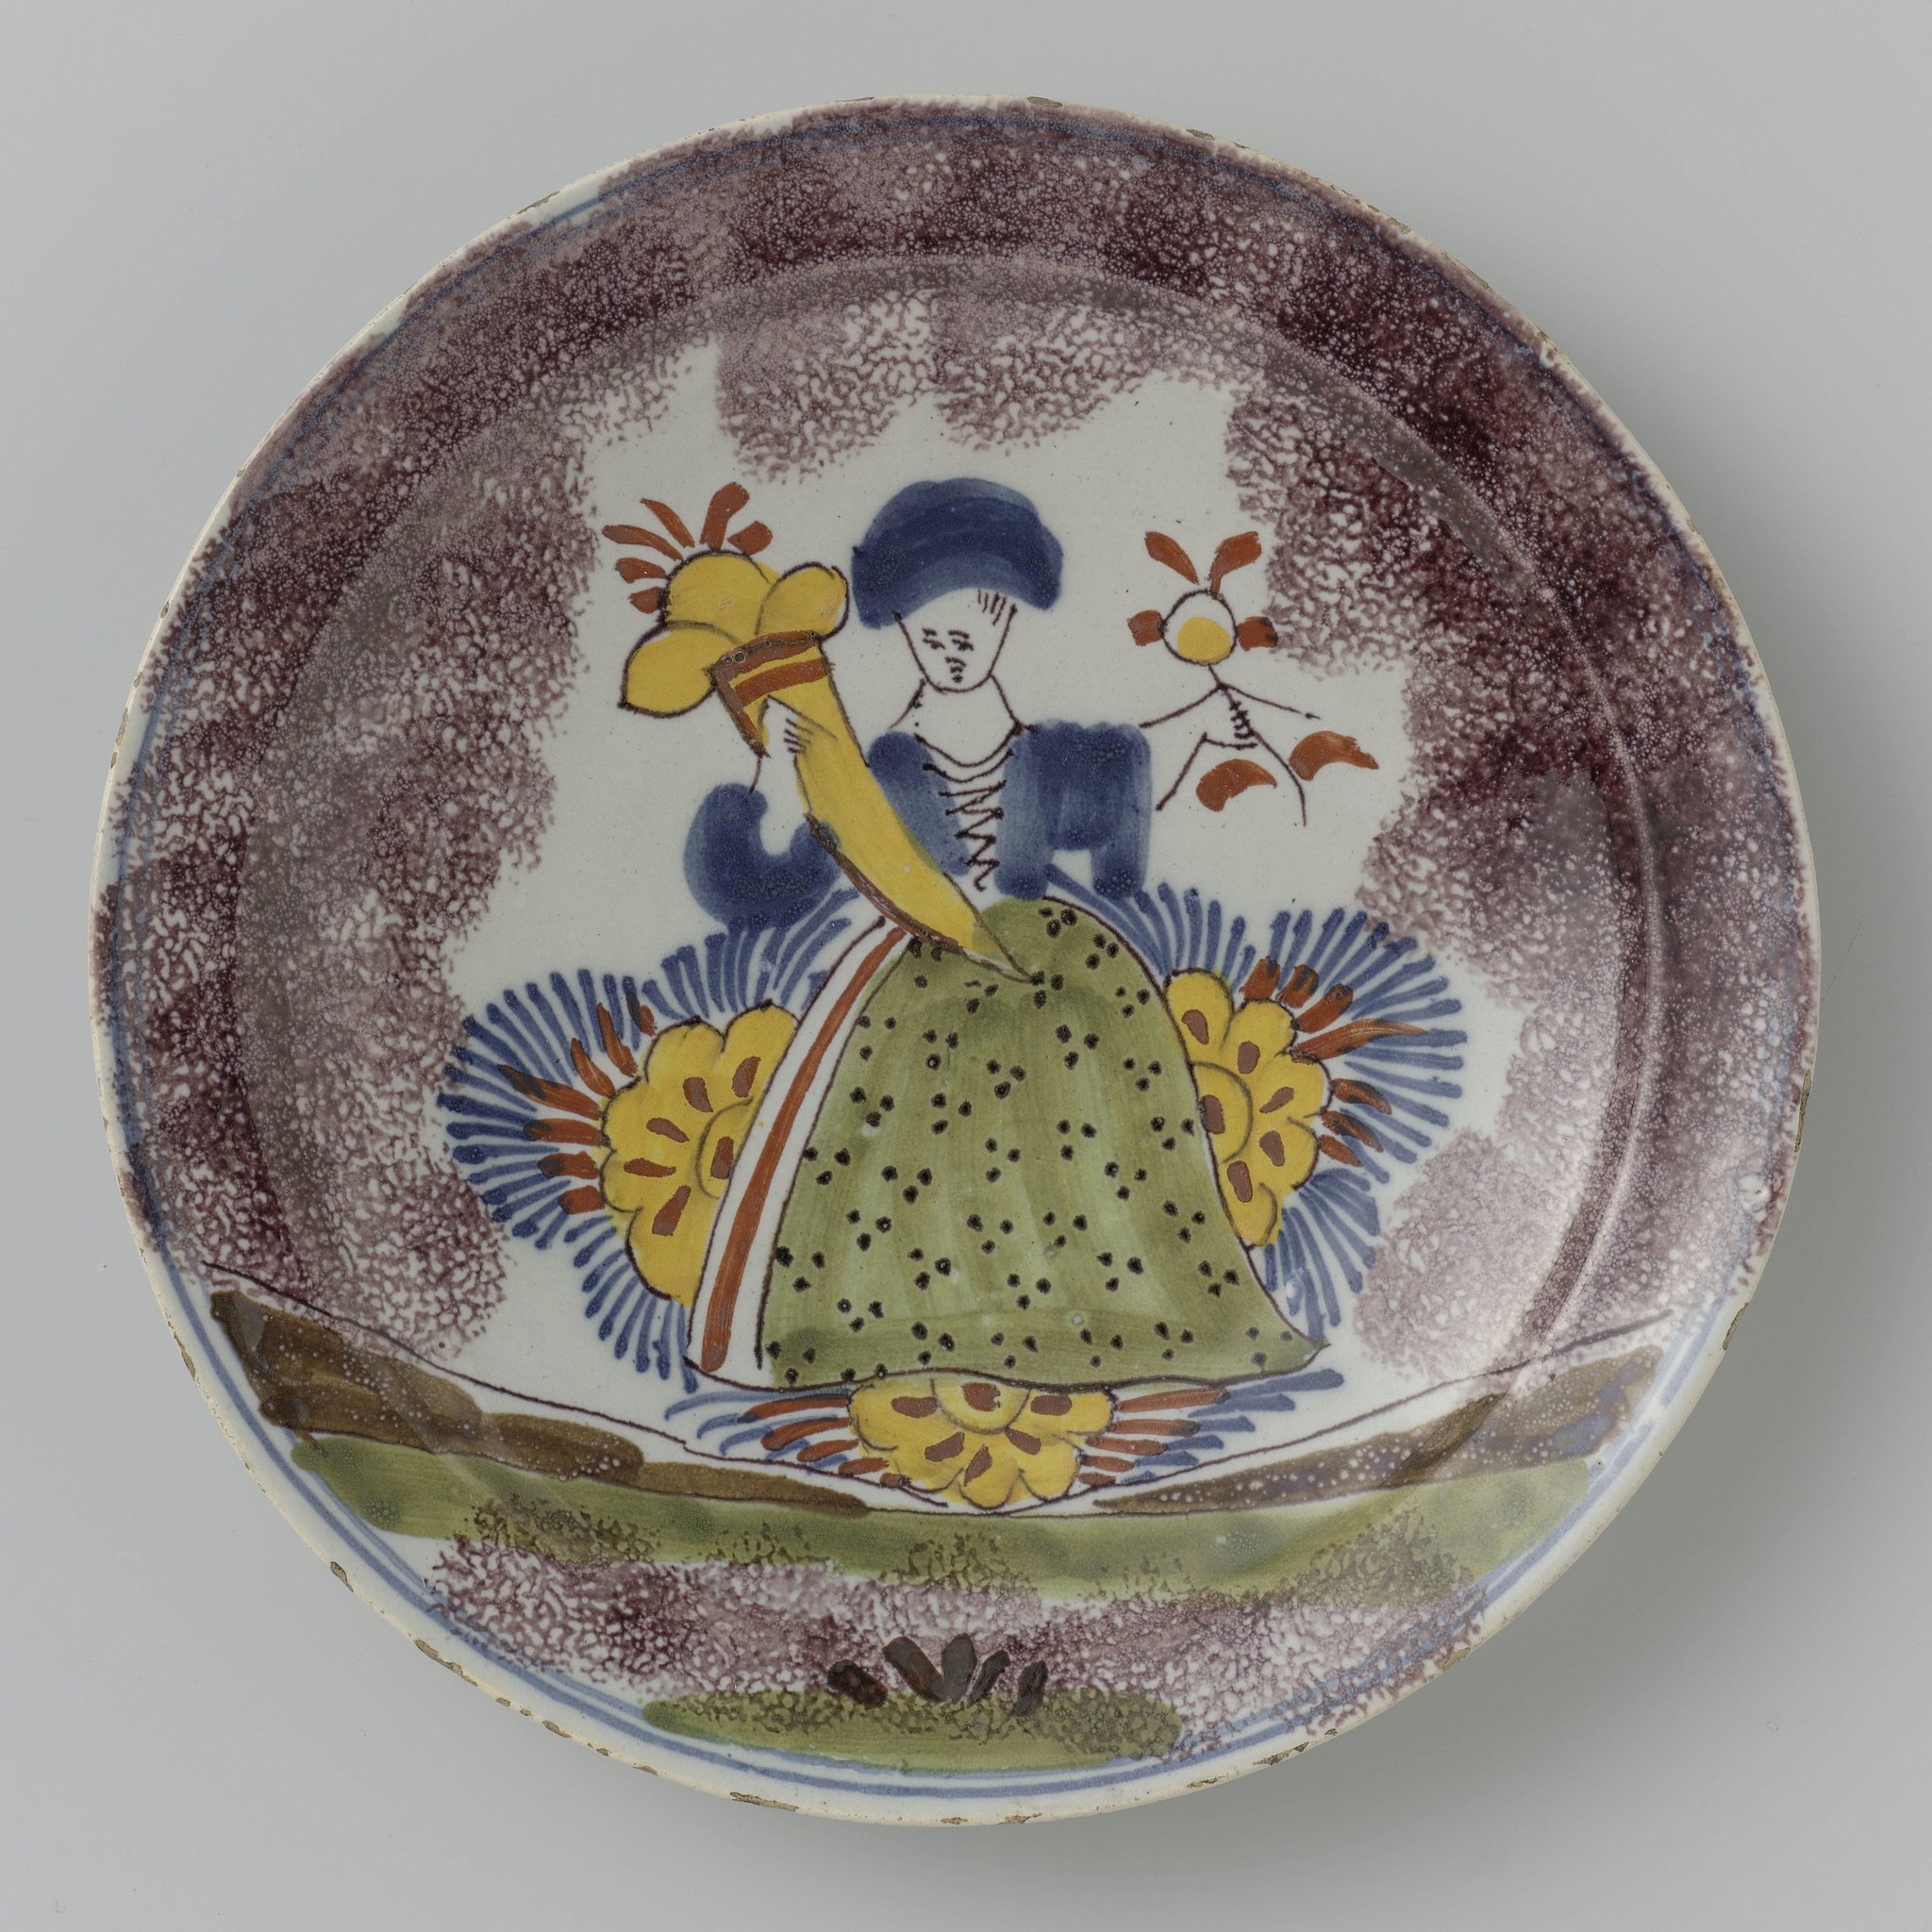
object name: plate dish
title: Bord van faience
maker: Anonymous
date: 1720-1770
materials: faience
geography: delft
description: Bord van faience veelkleurig beschilderd met een vrouwenfiguur.